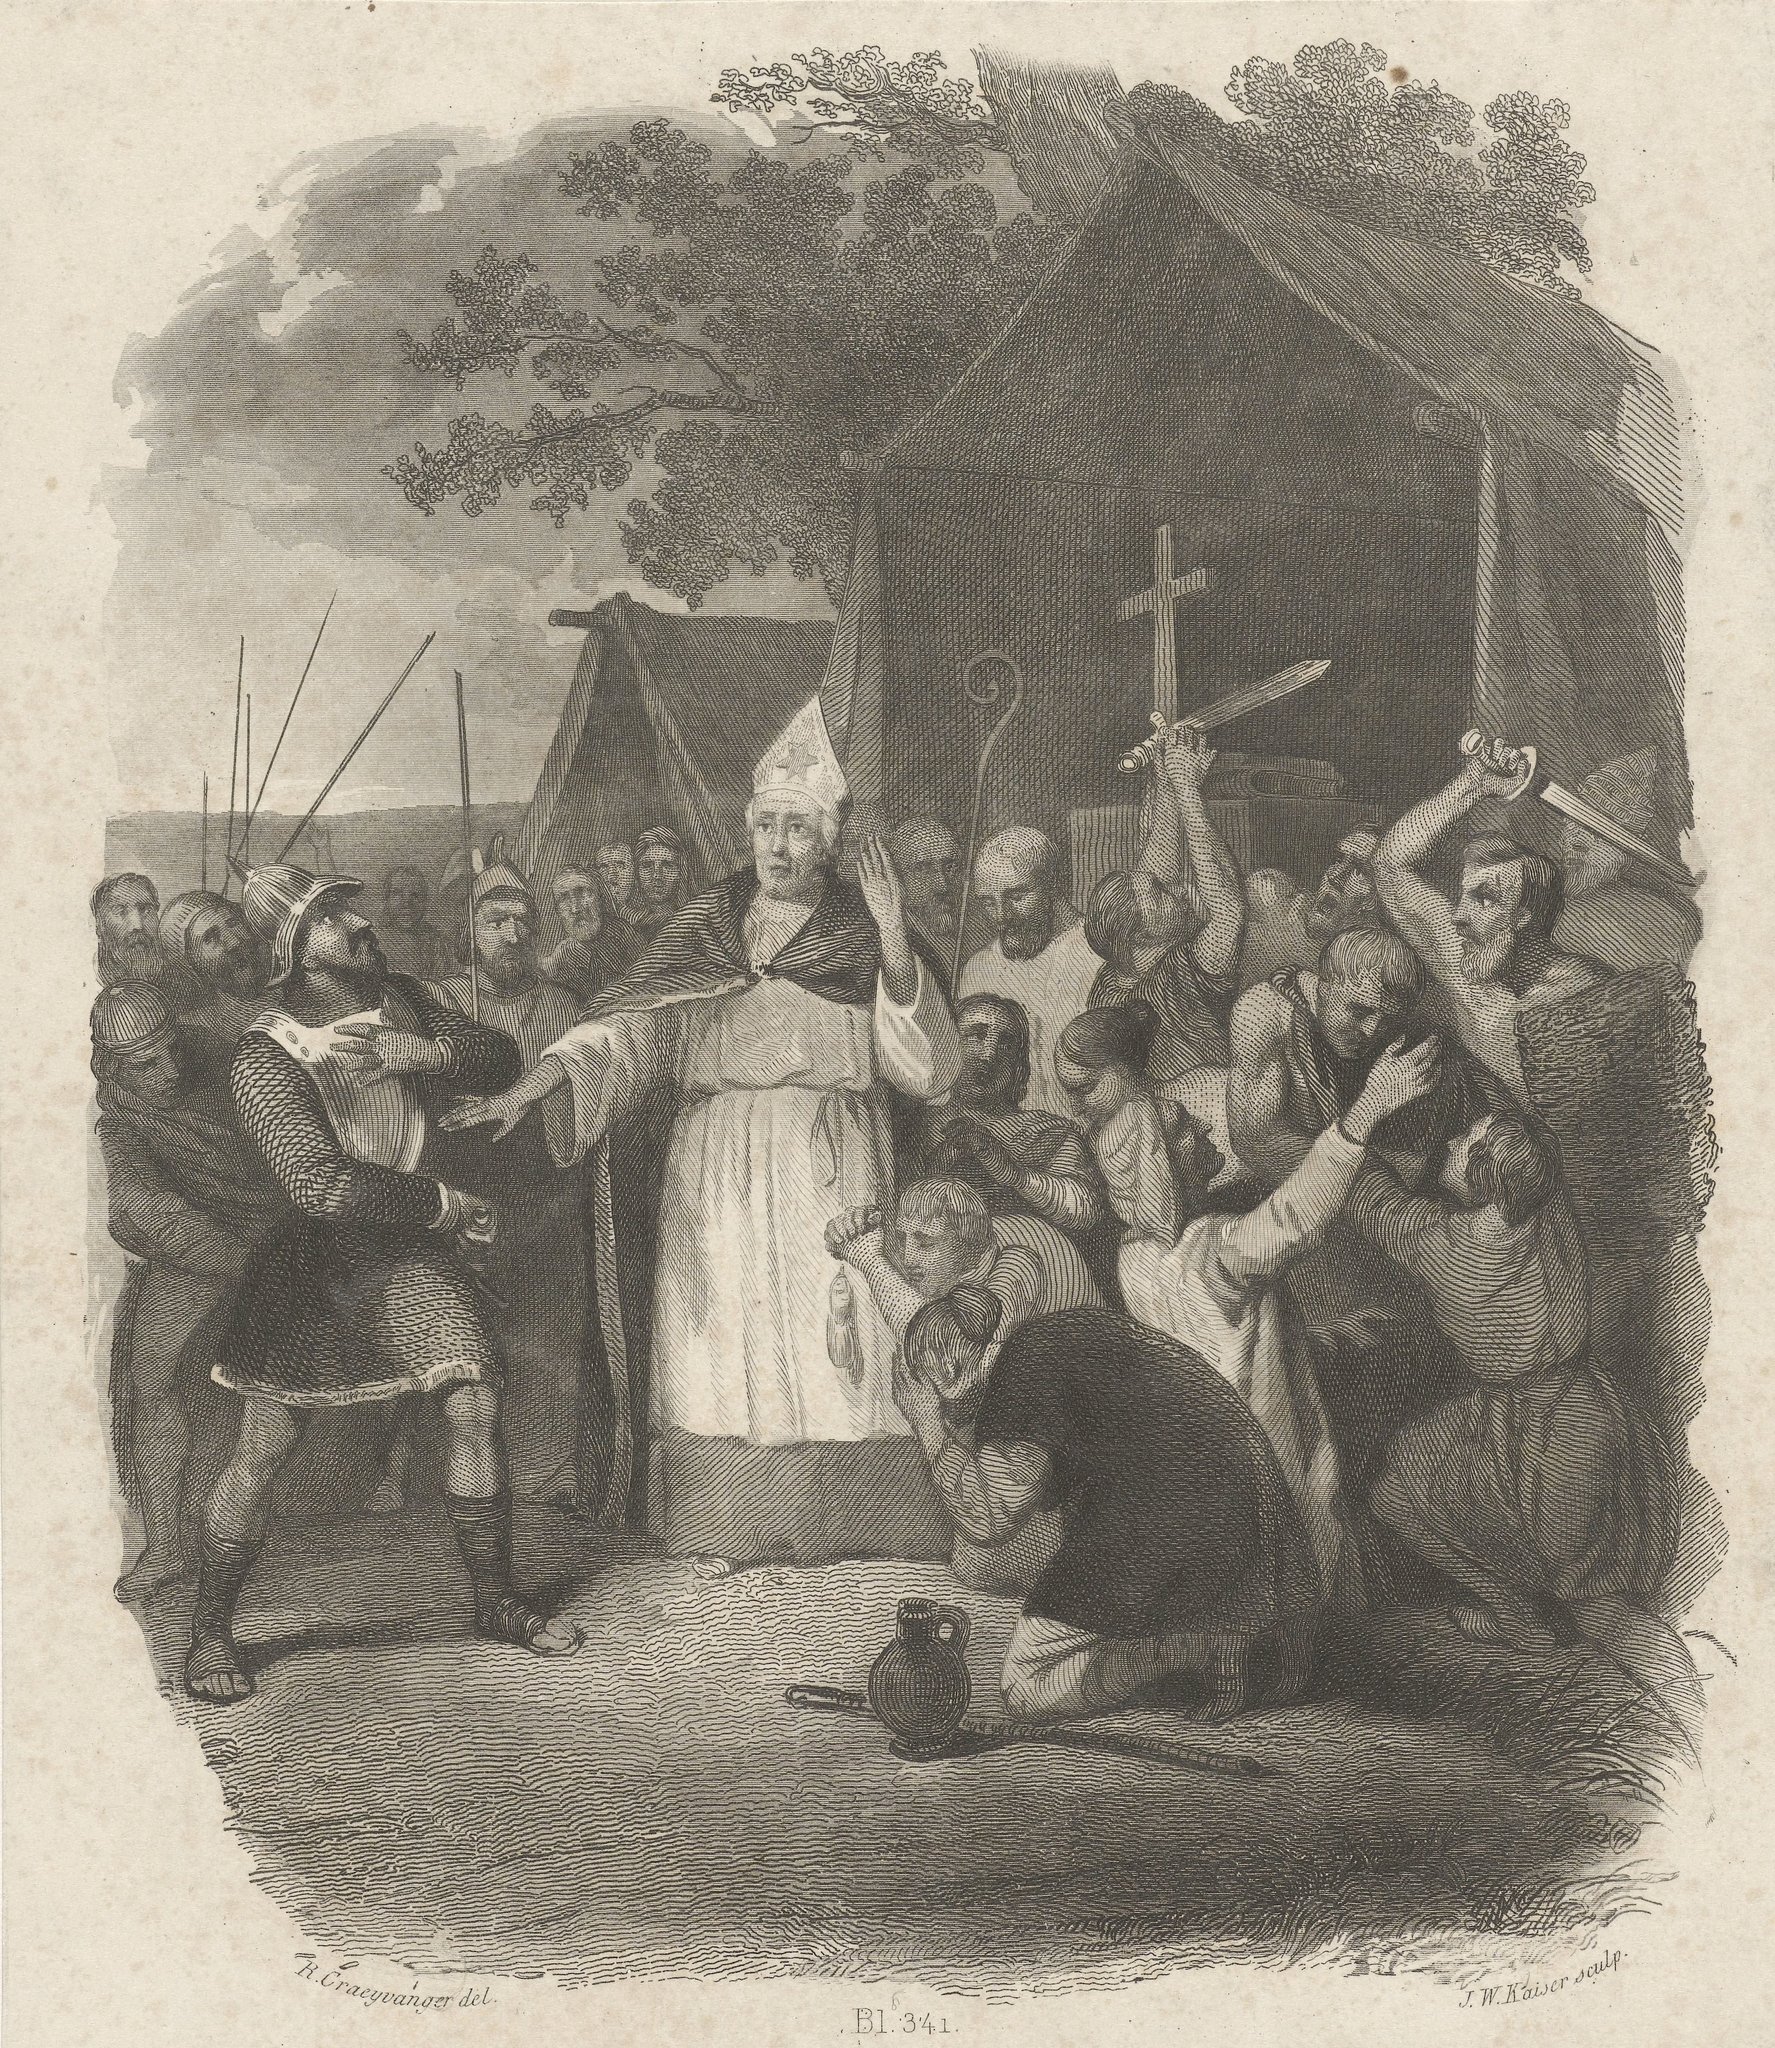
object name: book illustration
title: Bonifatius bij Dokkum vermoord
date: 1840-1884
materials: paper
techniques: etching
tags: the cross ~ symbols of christ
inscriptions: collector's mark: Lugt 2228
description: De marteldood van Bonifatius en zijn 53 volgelingen te Dokkum, in het jaar 754. Bonifatius staat voor een van zijn tenten te midden van een groep soldaten. Enkele soldaten hebben hun zwaard hebben getrokken. Links staat een krijgsman die zijn zwaard uit zijn schede haalt om de twee geknielde volgelingen van de bisschop te onthoofden.